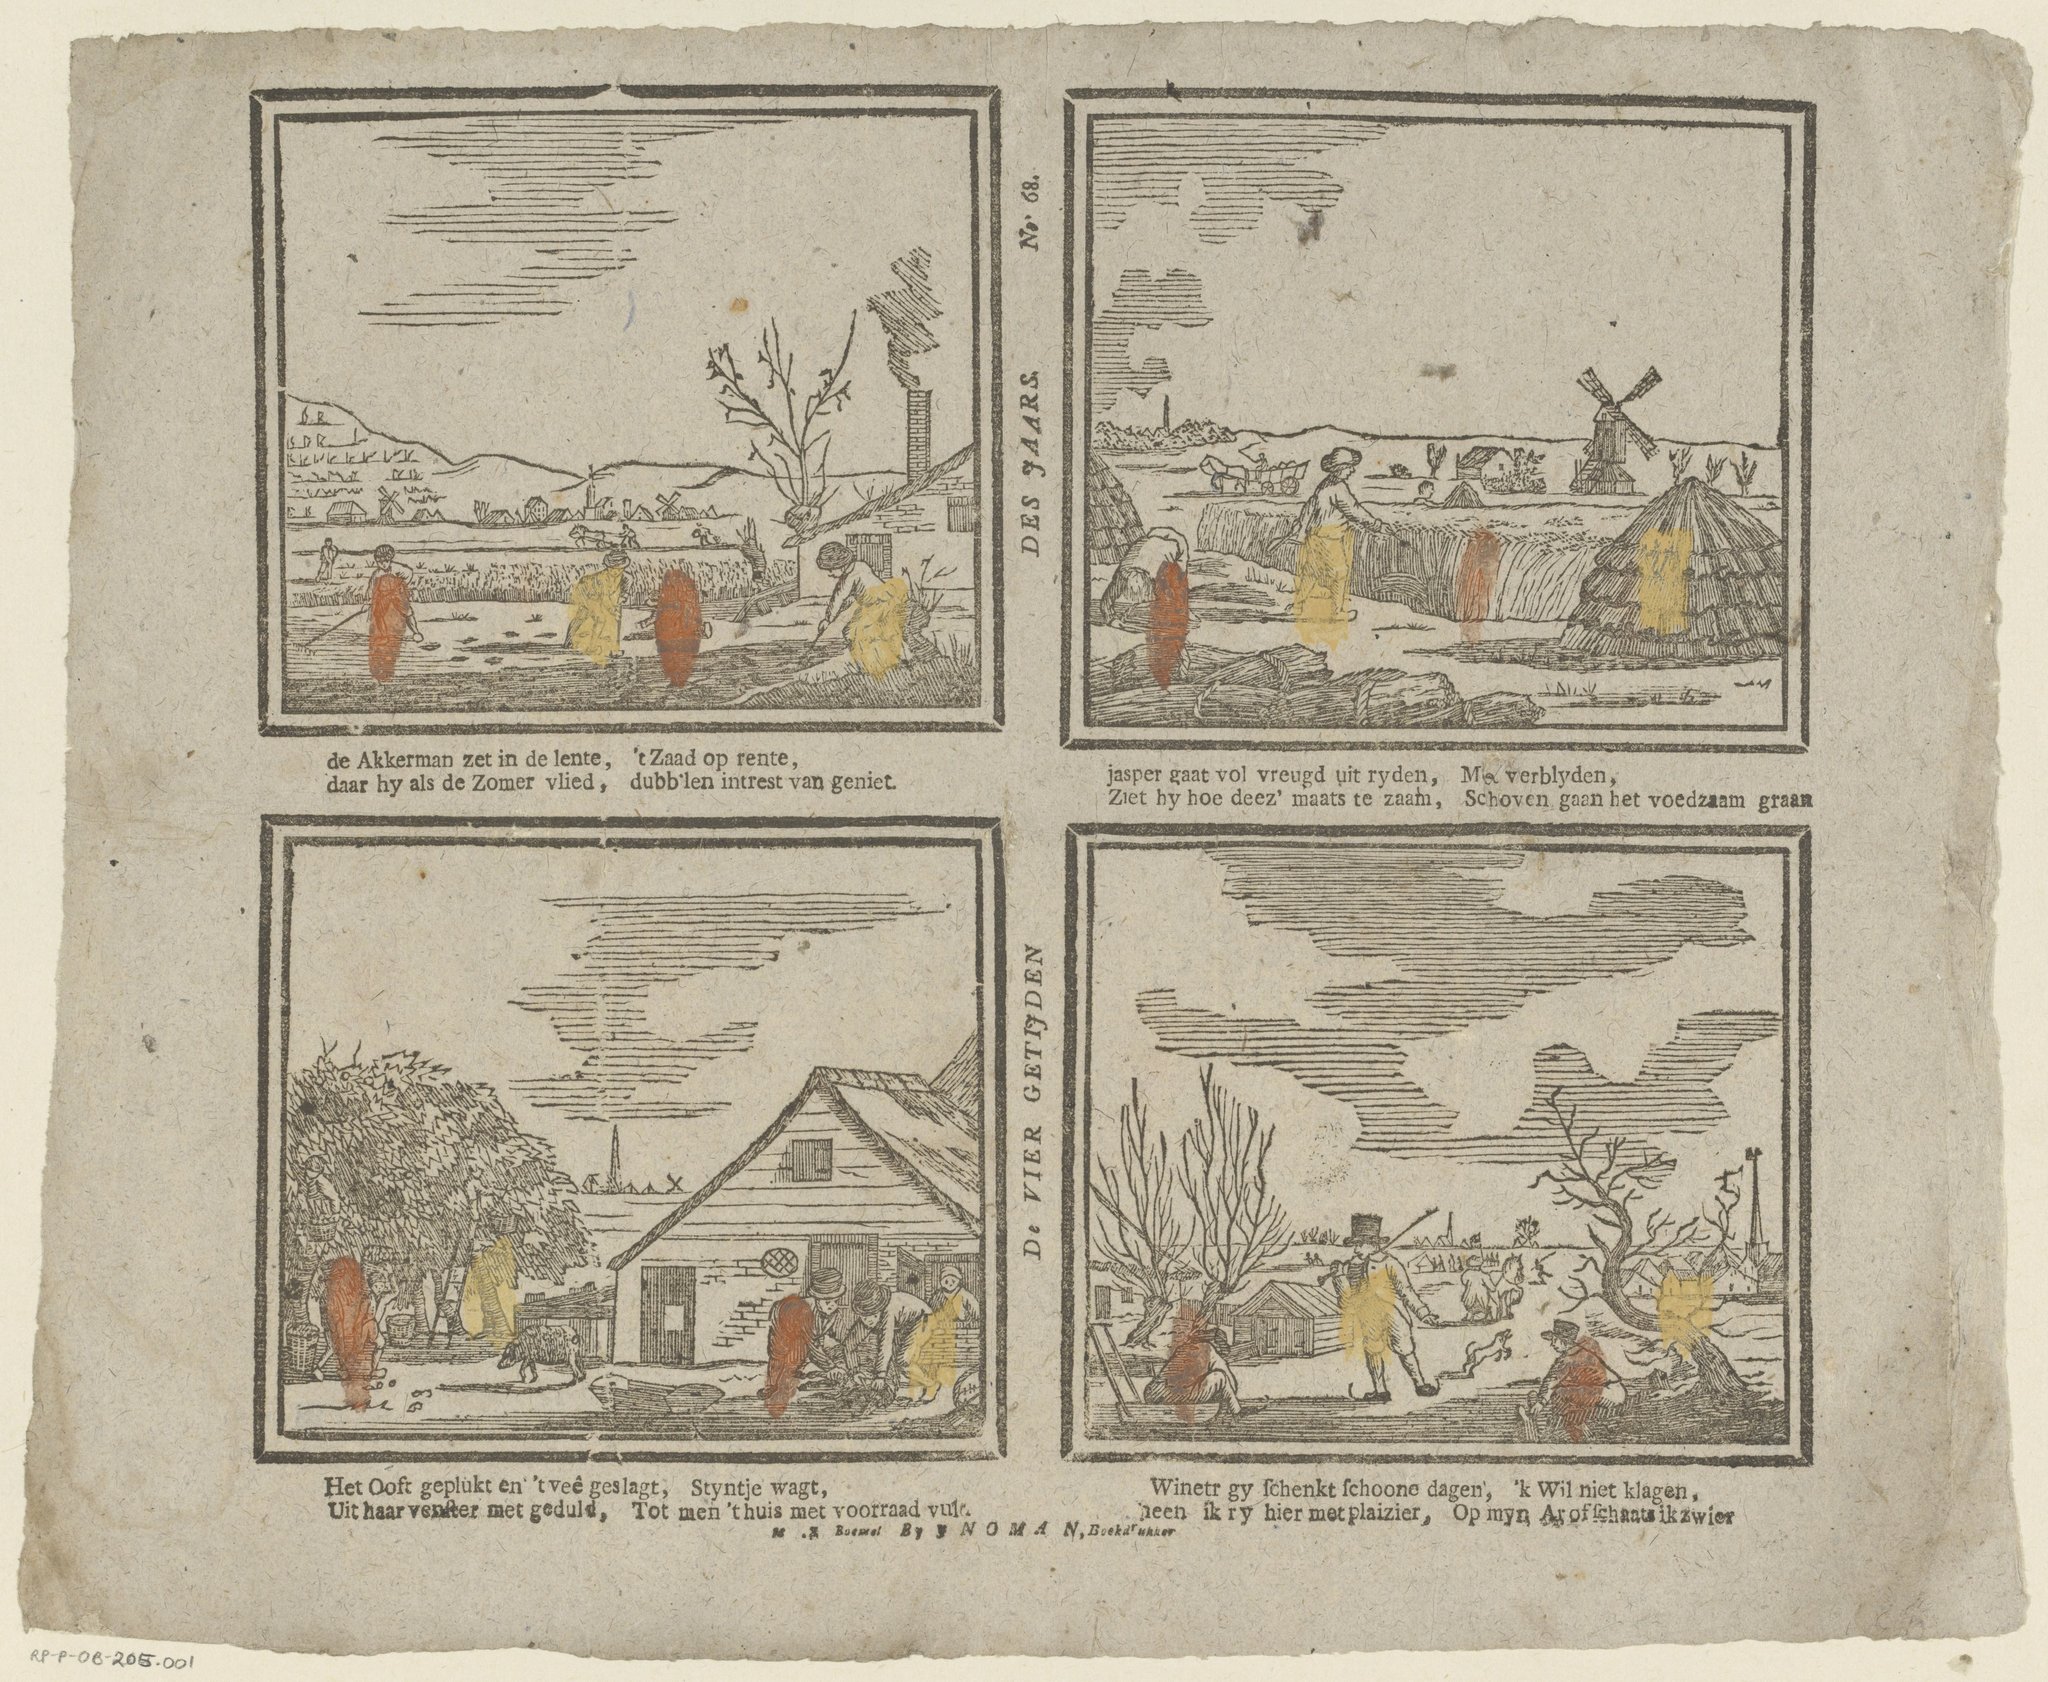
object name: print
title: De vier getijden des jaars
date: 1806-1830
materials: paper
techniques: colour, letterpress printing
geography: netherlands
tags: the four seasons of the year ~ human activities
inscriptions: collector's mark: Lugt 2760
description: Blad met 4 voorstellingen van de vier jaargetijden en bijbehorende activiteiten. Onder elke afbeelding een tweeregelig vers. Genummerd midden boven: No. 68.